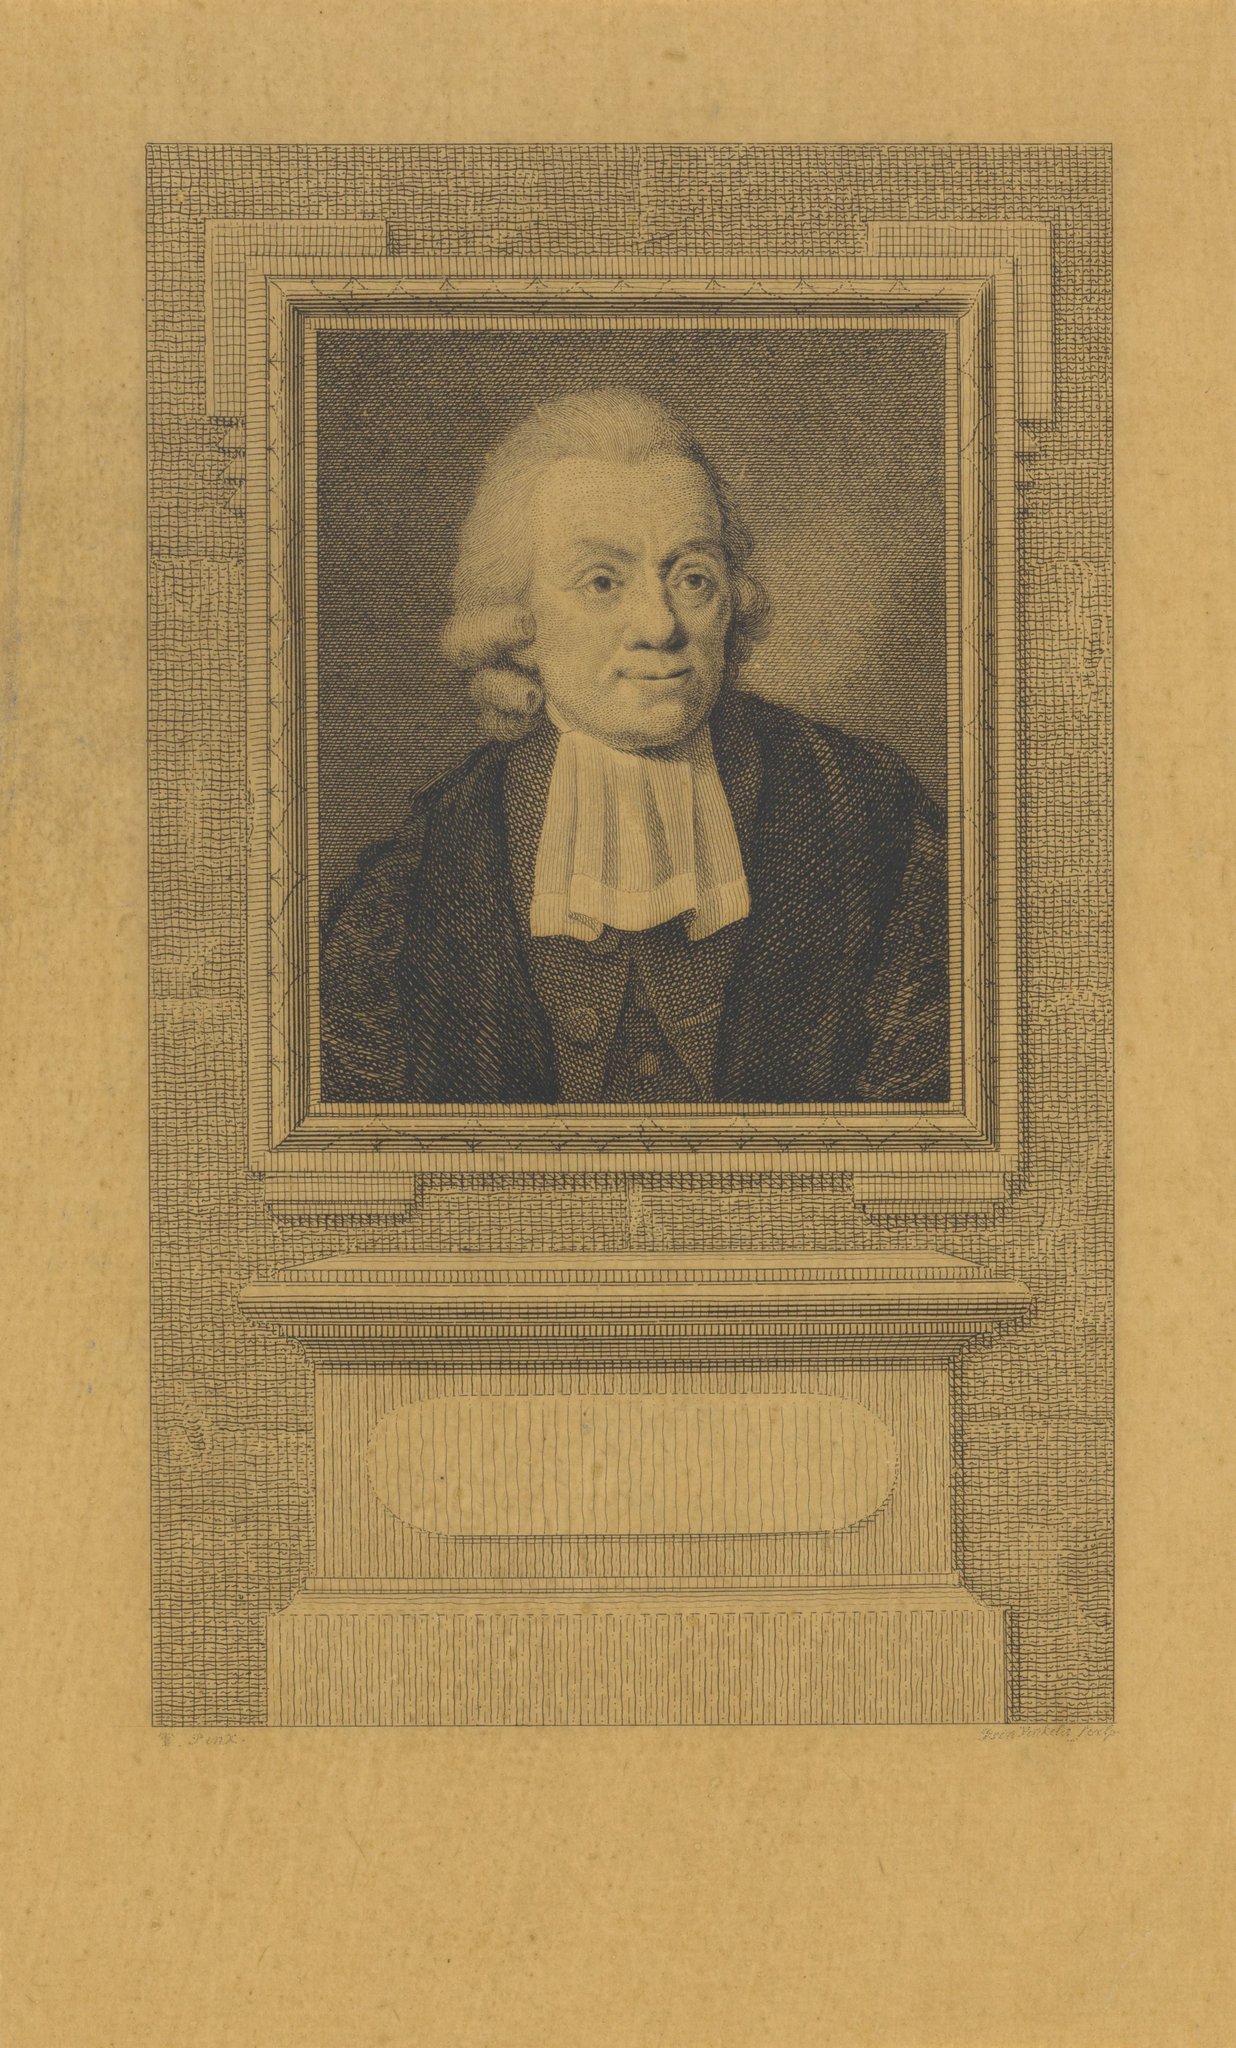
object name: print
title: Portret van Matthias van Geuns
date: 1786-1809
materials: paper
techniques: engraving, etching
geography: amsterdam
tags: groningen, geneeskundige, matthias van geuns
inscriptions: collector's mark: Lugt 2228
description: Latere staat prent gebruikt als boekillustratie in: Wagenaar, Jan. Vaderlandsche historie, (...) ten vervolge van Wagenaars Vaderlandsche historie. Dl. 1-43. Amsterdam: Johannes Allart, 1786-1809.